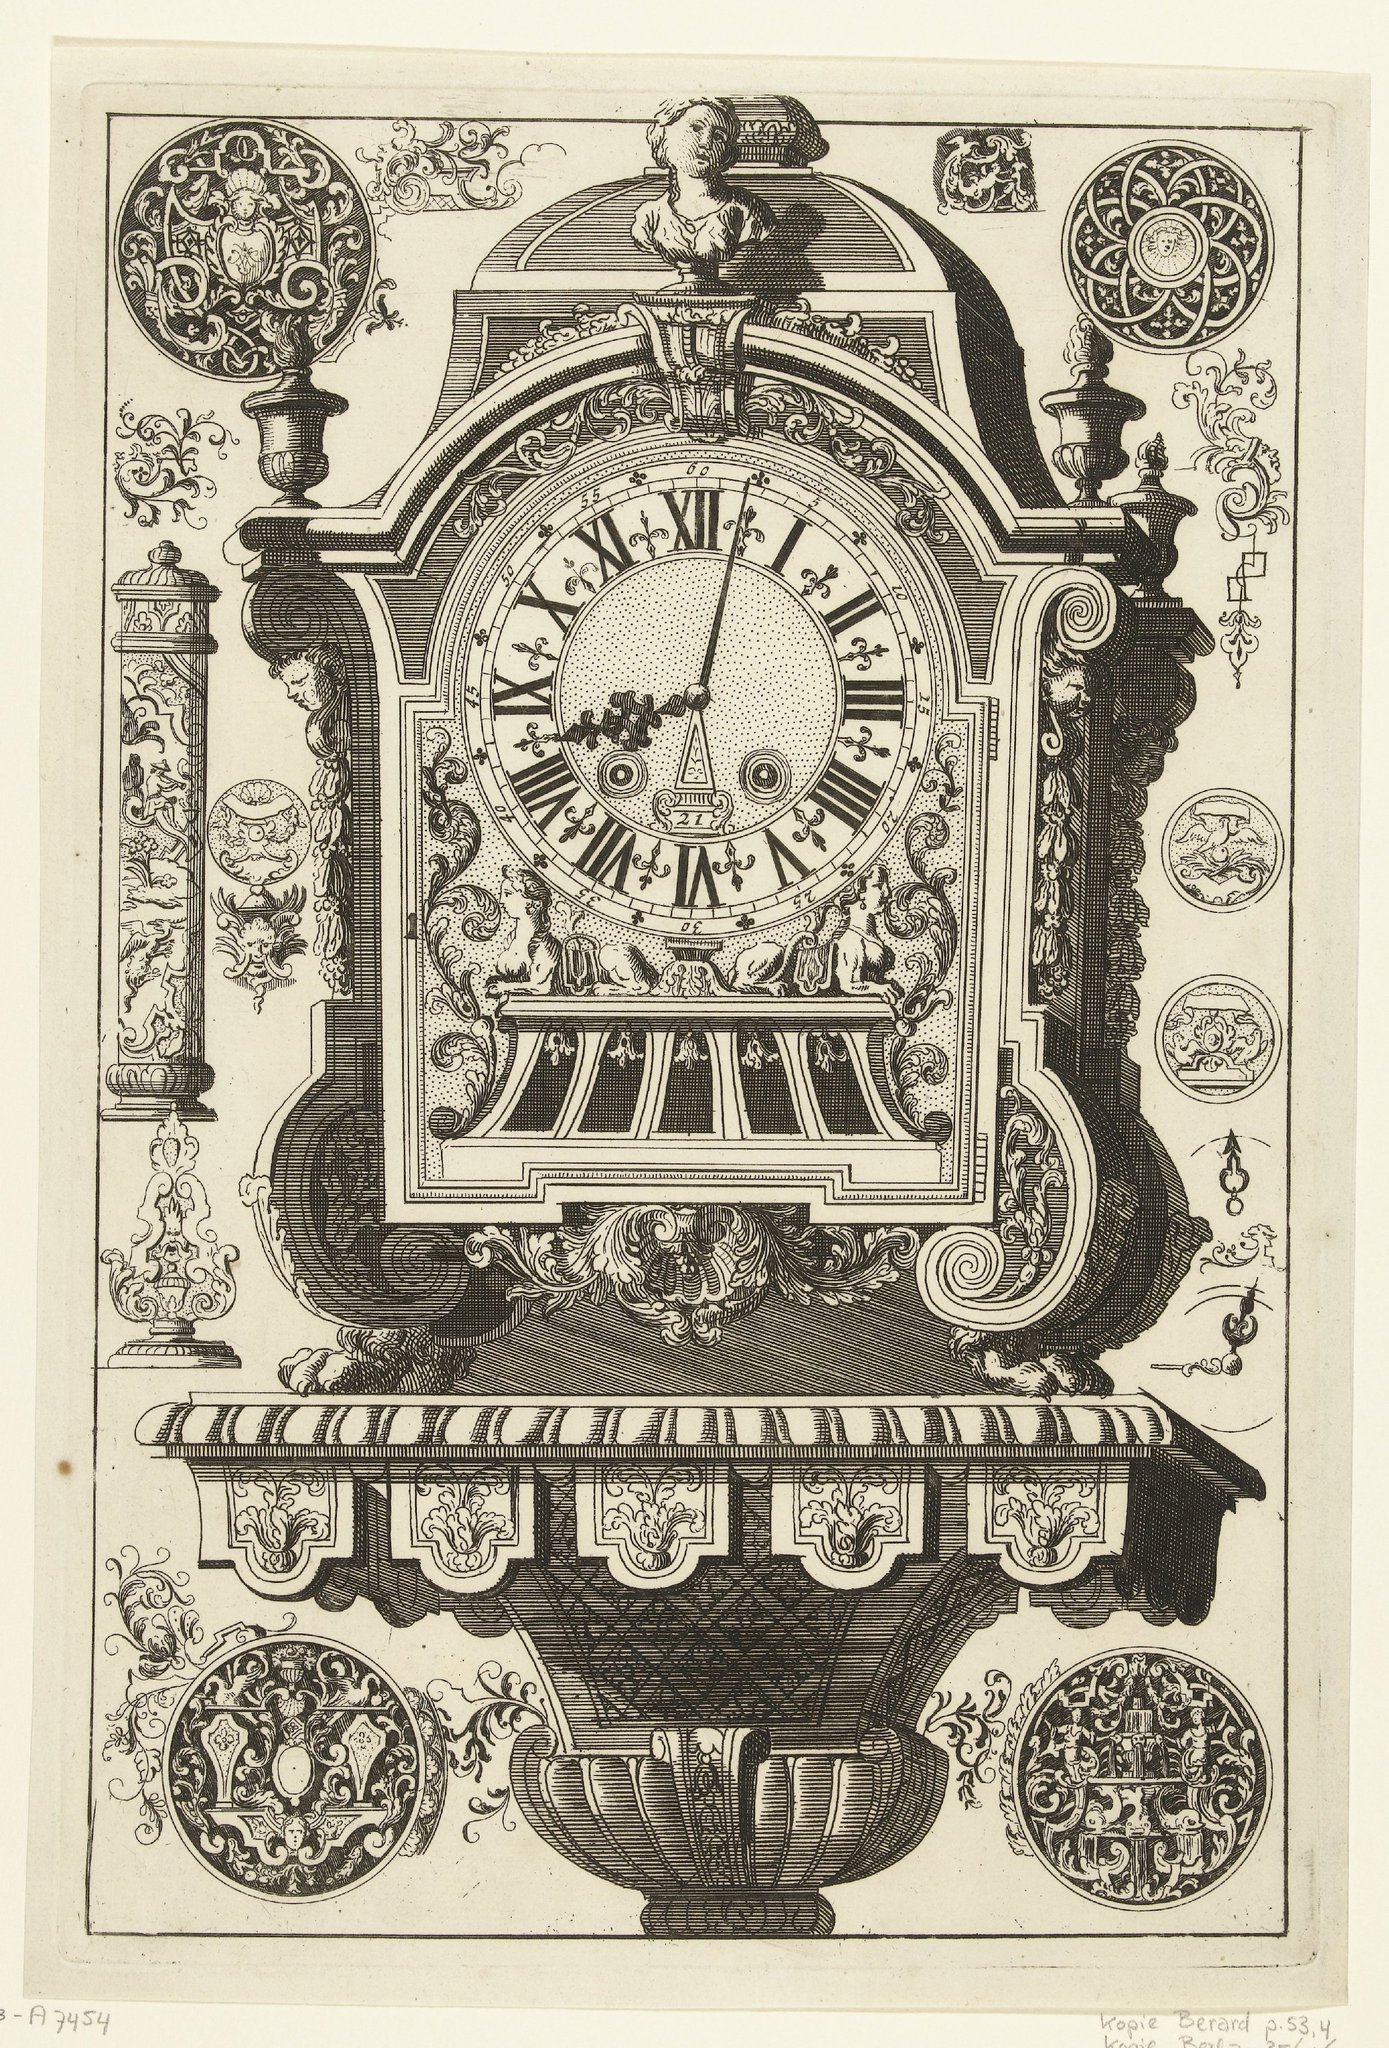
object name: print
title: Nouveaux Liure de Boites de Pendulles de Coqs et Etuys de montres et autres necessaire au Orlogeurs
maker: Anonymous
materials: paper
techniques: etching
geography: netherlands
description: Pendule bekroond met een vrouwelijke buste. De pendule is omringd door vier decoraties voor wijzerplaten en twaalf andere motieven. Kopie van blad 5 uit de serie Nouveaux Liure de Boïtes de Pendulles, uitgegeven door Daniel Marot omstreeks 1706. Blad uit tweede editie.